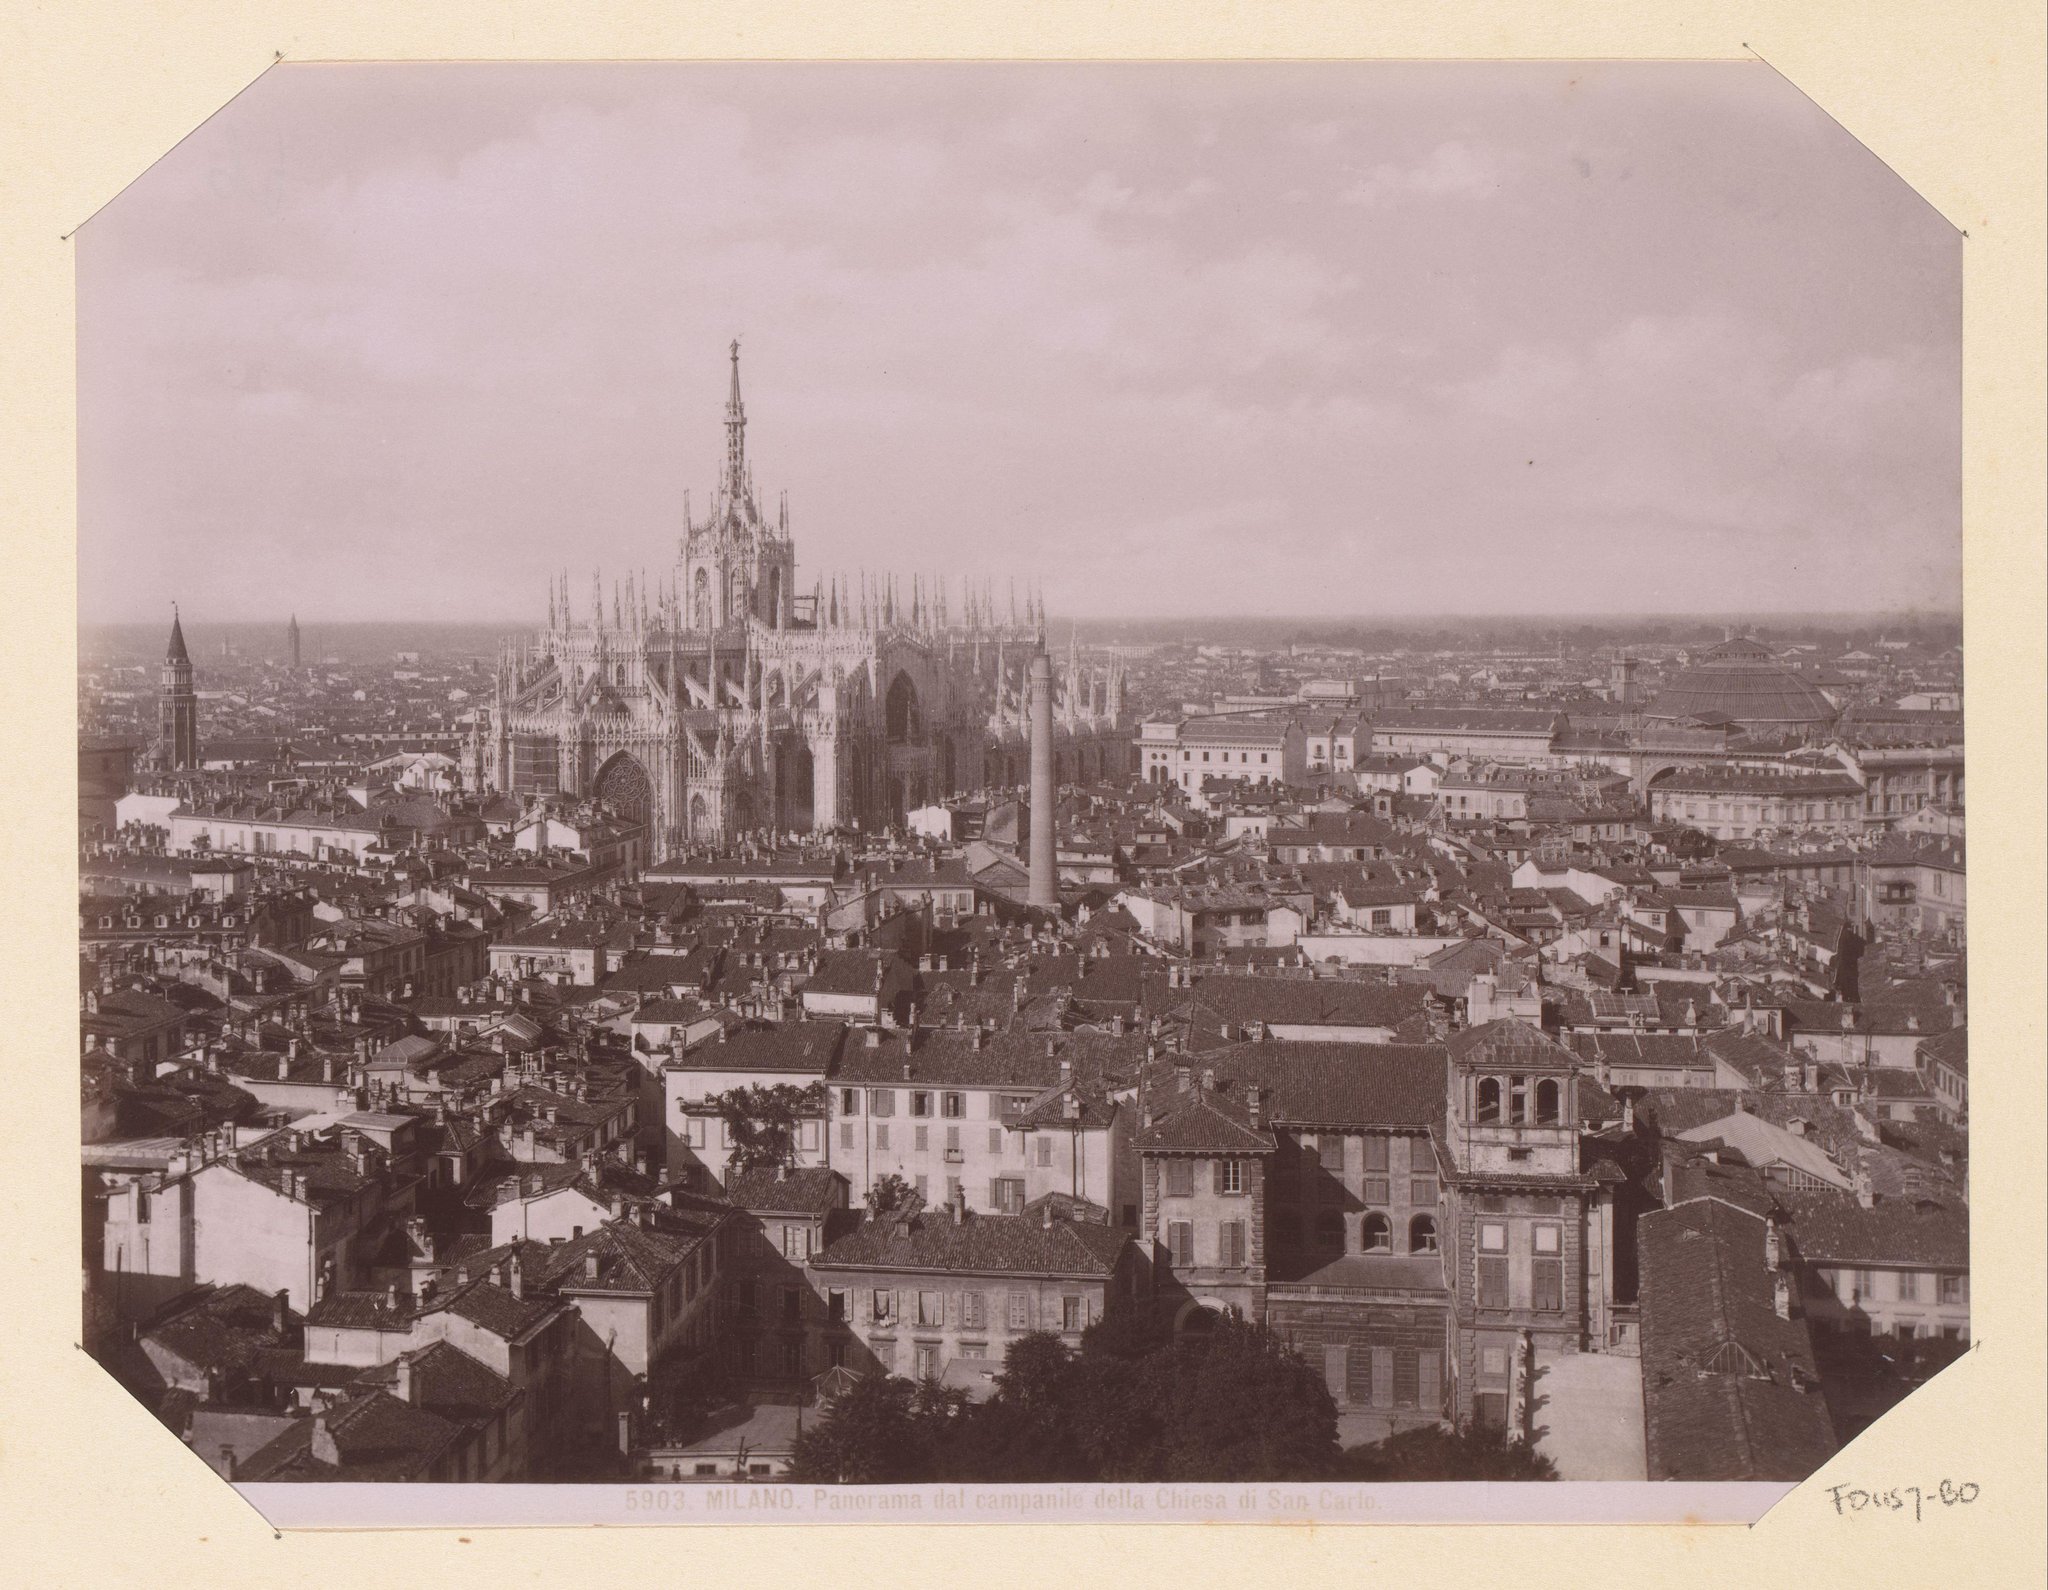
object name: photograph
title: Milano. Panorama dal campanile della Chiesa di San Carlo.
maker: Anonymous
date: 1885-1892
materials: photographic support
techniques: albumen print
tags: city-view in general; 'veduta', church (exterior)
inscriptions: number: ‘5903’, annotation: ‘Milaan - Panorama’